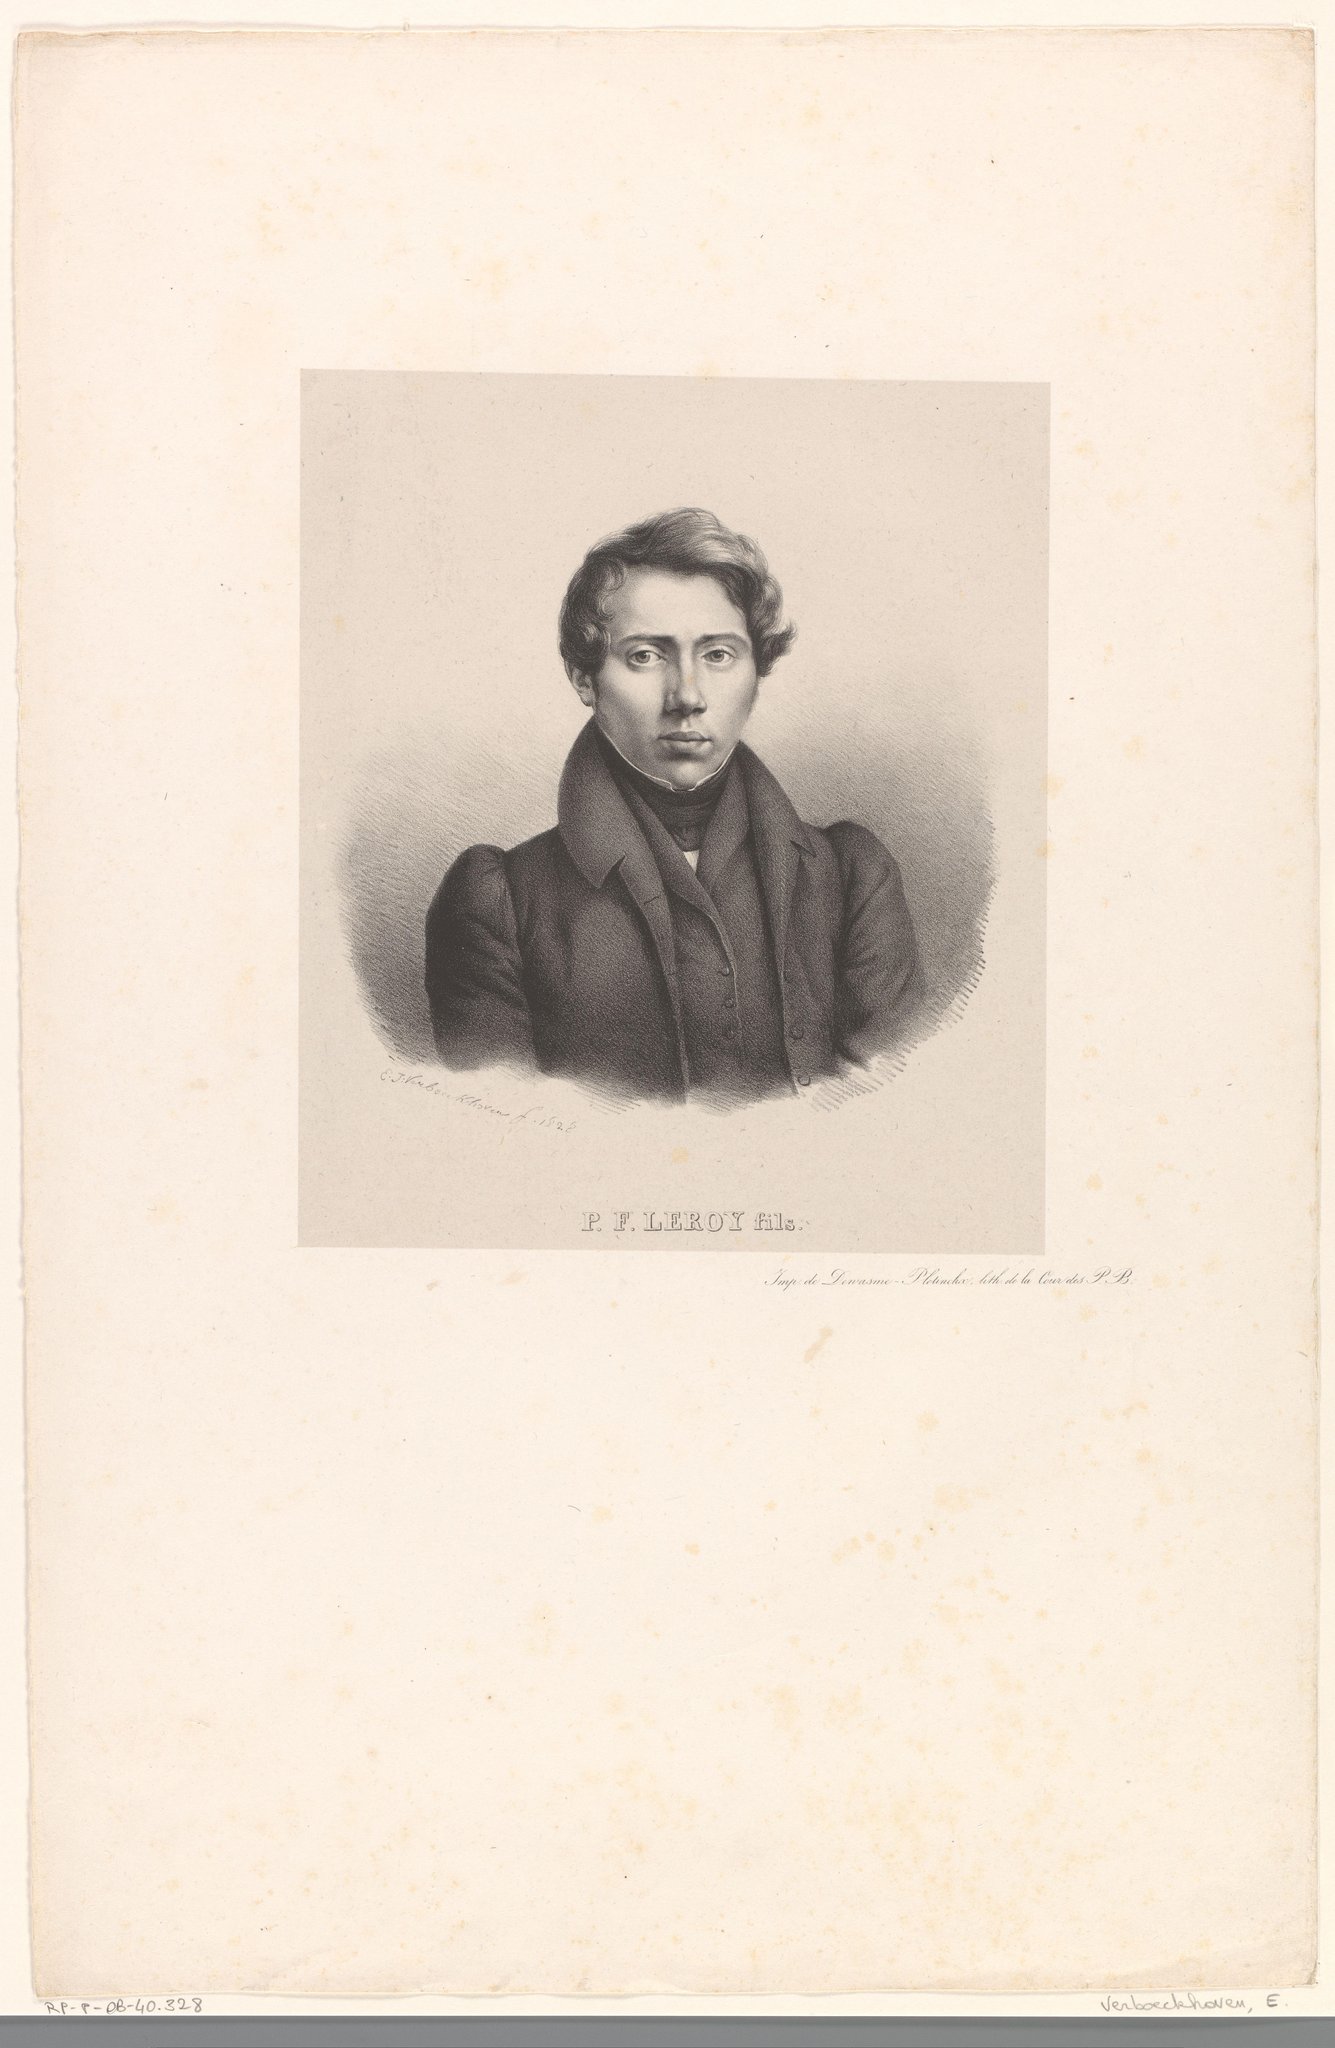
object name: print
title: Portret van Pierre François Le Roy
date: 1828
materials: paper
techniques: lithograph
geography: brussels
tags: brussels, painter, print maker, pierre-françois le roy, historical persons, portrait, self-portrait of painter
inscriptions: date